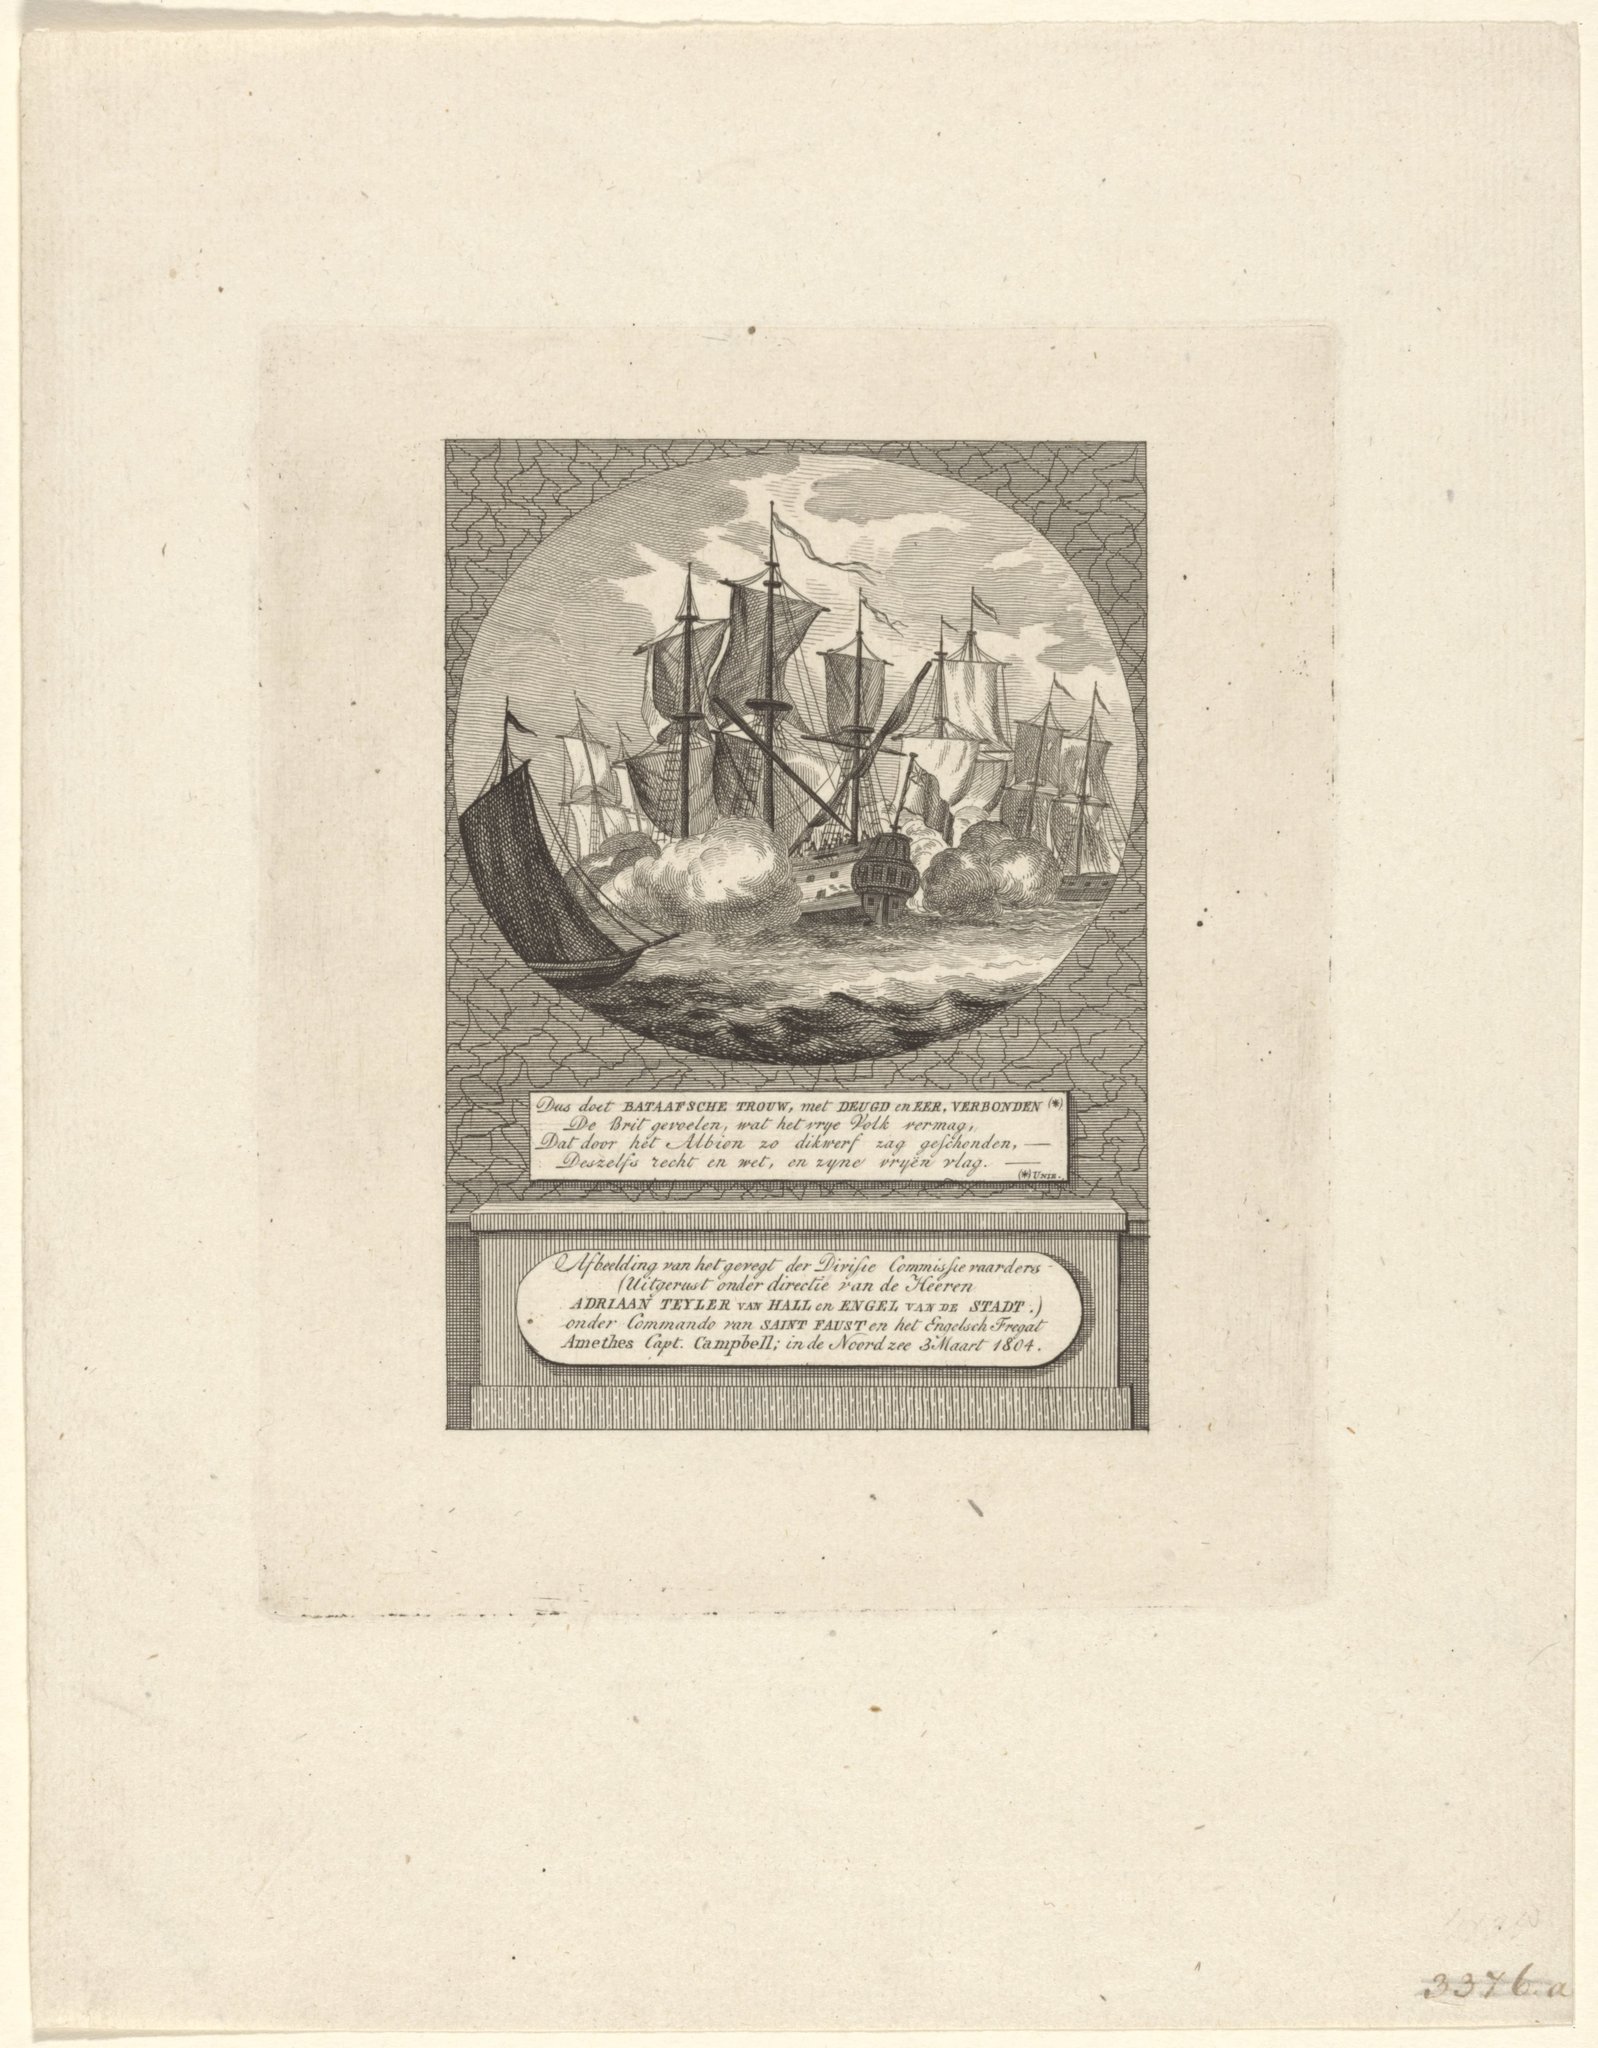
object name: print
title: Afbeelding van het gevegt der Divisie Commissievaarders (Uitgerust onder directie van de Heeren Adriaan Teyler van Hall en Engel van de Stadt.) onder Commando van Saint Faust en het Engelsch Fregat Amethes Capt. Campbell; in de Noordzee 3 Maart 1804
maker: Anonymous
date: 1805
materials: paper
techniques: engraving, etching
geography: netherlands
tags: battle (+ naval force)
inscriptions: collector's mark: Lugt 2228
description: Ronde voorstelling van het gevecht op de Noordzee op 3 maart 1804 tussen vier Nederlandse kaperschepen onder commando van Jean Saint-Faust met een Engels fregat genaamd Amethes onder bevel van kapitein Campbell. Met vierregelig onderschrift. Overdruk uit de Nederlandse Mercurius van 1805.